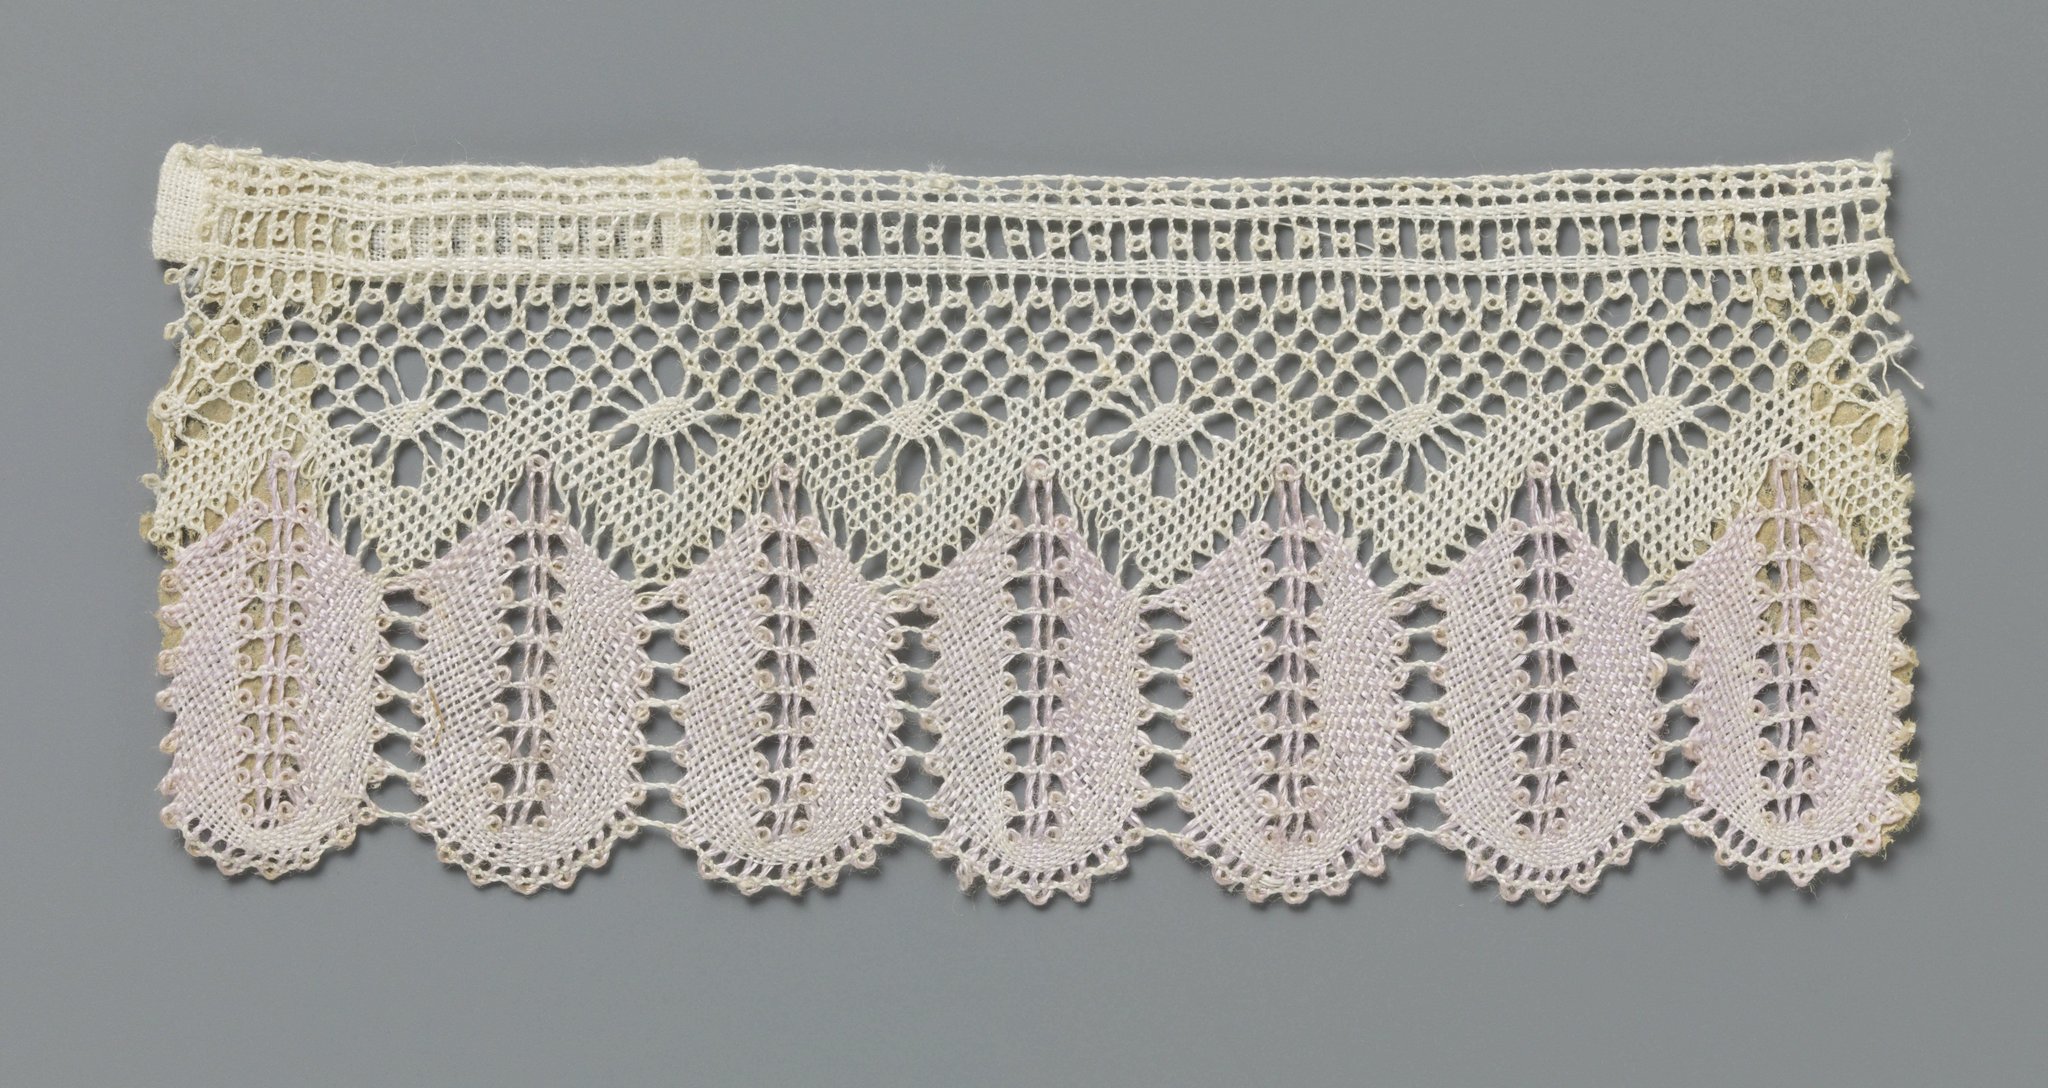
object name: strip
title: Strook lila-witte kloskant met hangende korenaren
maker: Anonymous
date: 1850-1900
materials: linen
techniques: lace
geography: russia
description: Strook gekleurde - lila-witte - kloskant: stropkant. Het zich herhalende patroon bestaat uit gestileerde hangende korenaren in linnenslag met een opengewerkt centrum. De korenaren zijn lila van kleur en hangen recht naar beneden, ze zijn tegen elkaar aan geplaatst en vormen een schulpenrand langs de onderzijde van de strook. Bovenaan de strook beginnen de korenaren vanuit een omgekeerd v-vormig motief gemaakt in netslag. Ze zijn aan de bovenkant van de strook met elkaar verbonden door een traliegrond, een stroptraliegrond, waarin steeds één spitsovaaltje in linnenslag is verwerkt tussen de korenaren in. De bovenzijde van de strook is recht afgewerkt. De schulpenrand is afgewerkt met picots.